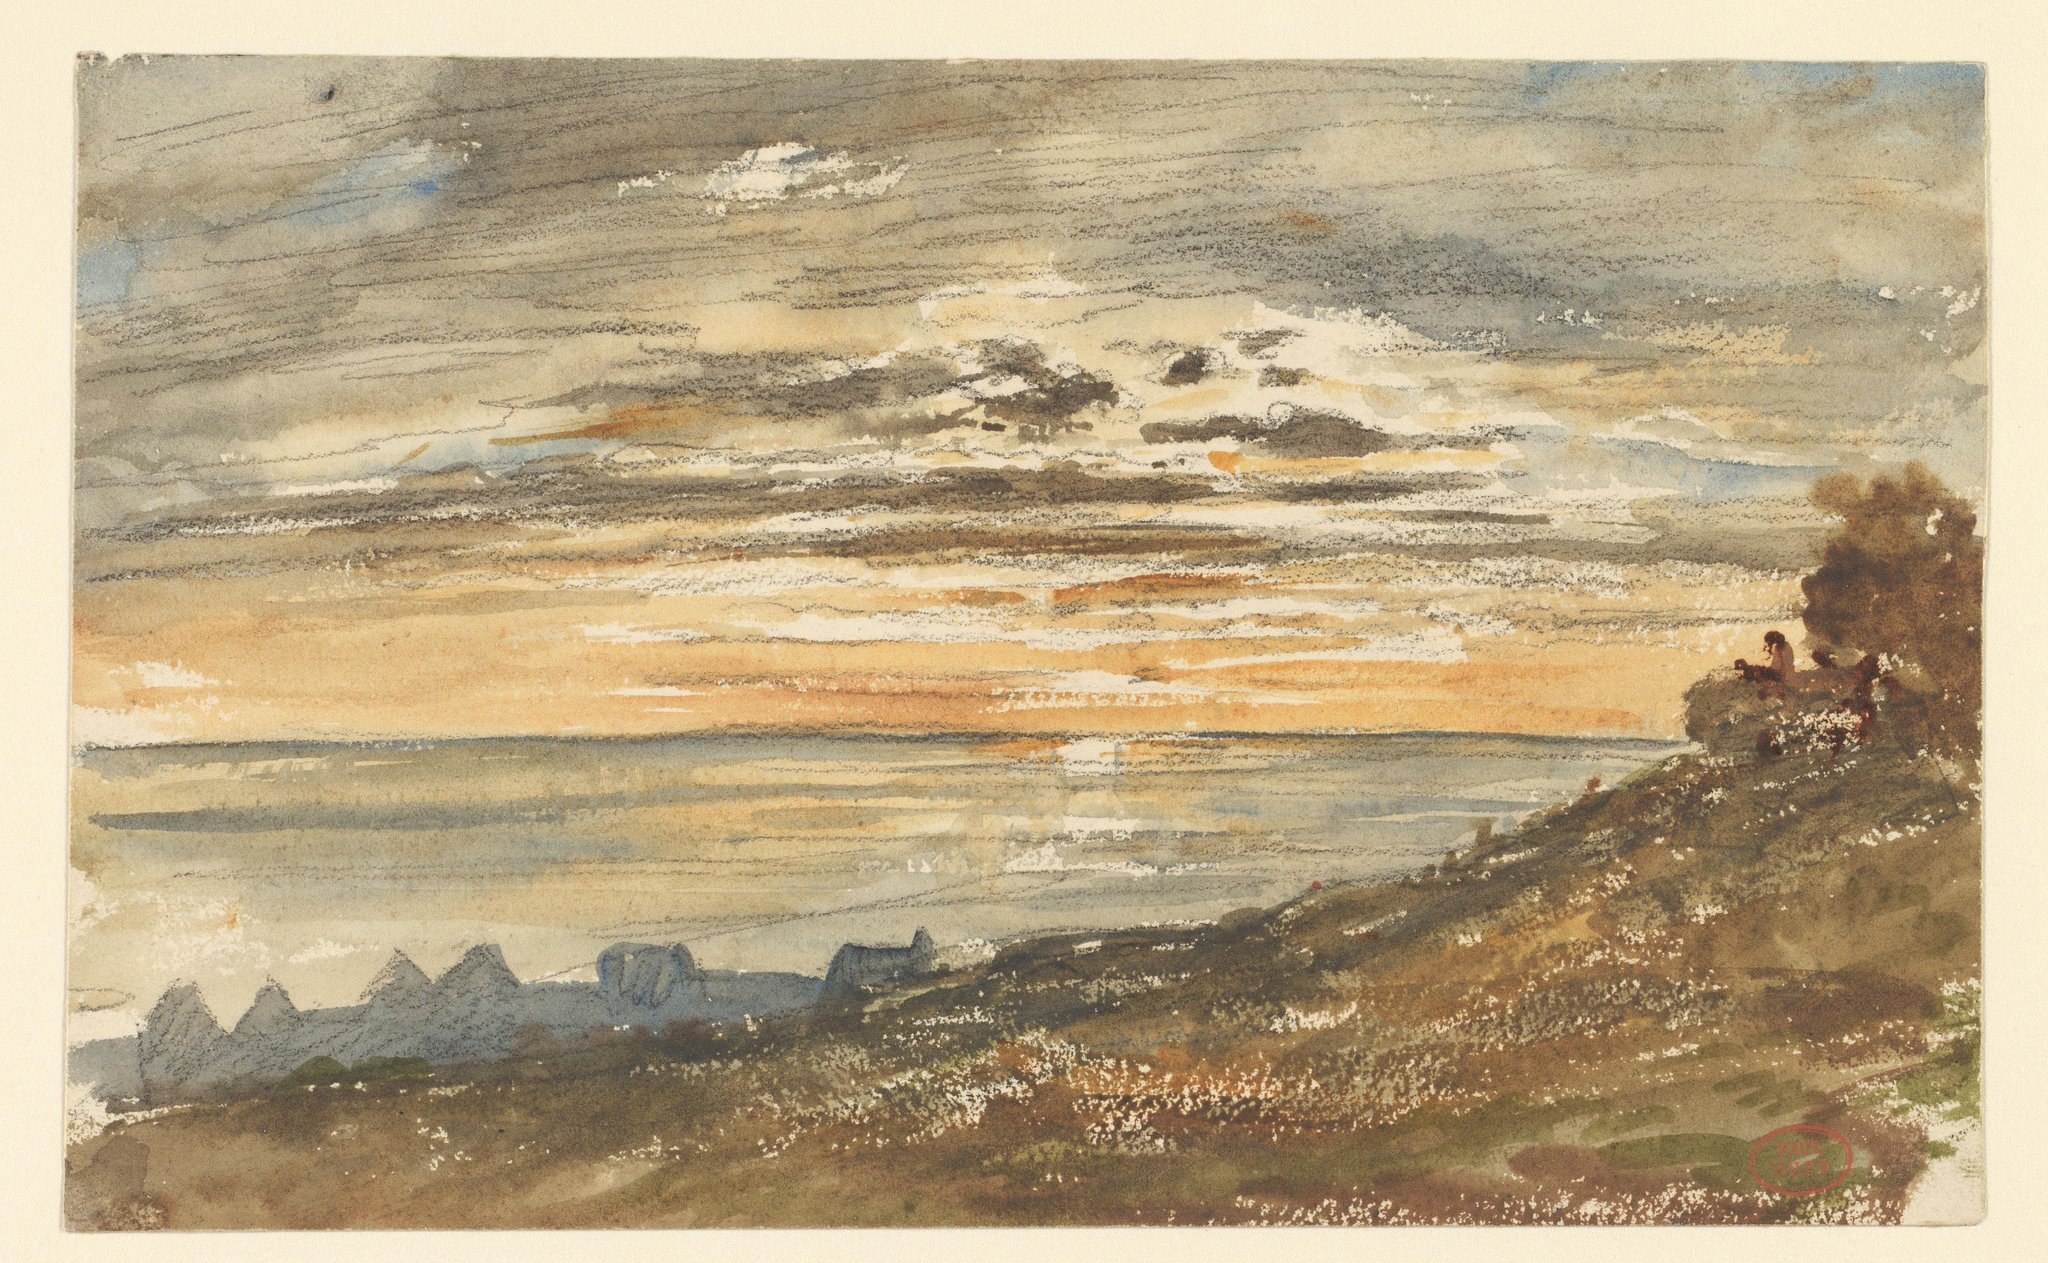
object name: drawing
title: Ondergaande zon te Trouville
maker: paul huet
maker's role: draughtsman, print maker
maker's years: 1803-1869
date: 1813-1869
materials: chalk, paper, watercolor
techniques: brush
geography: france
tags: sunset, coast